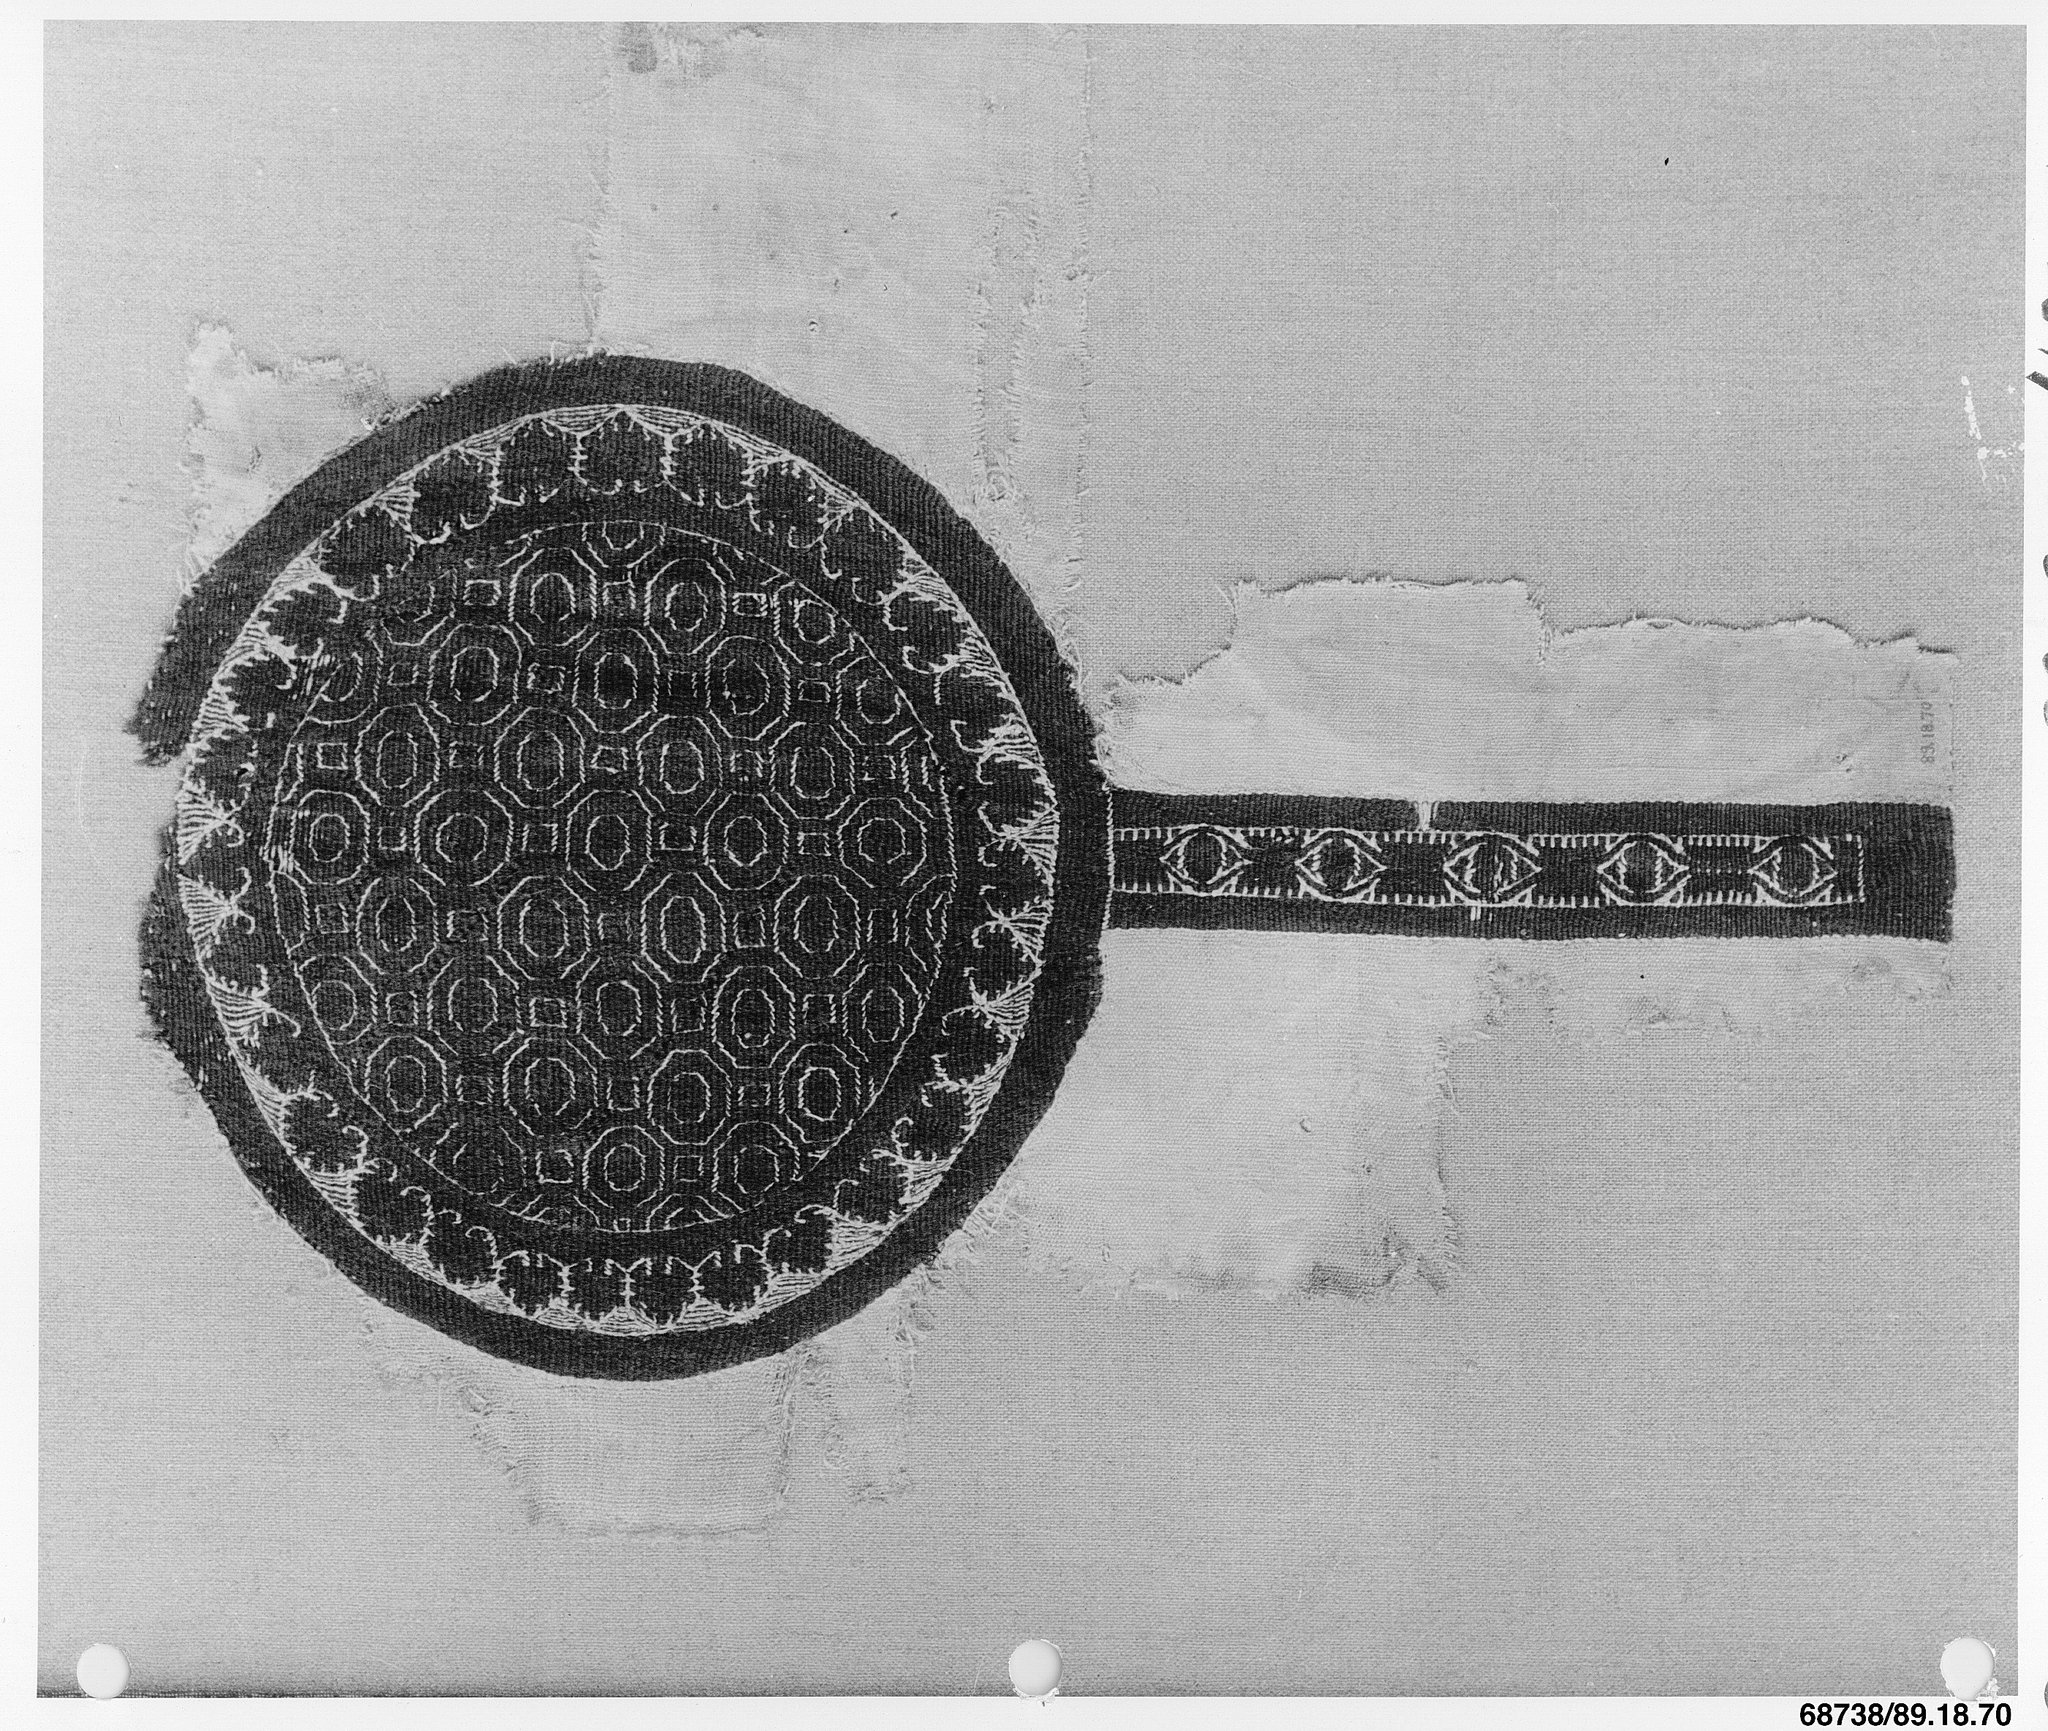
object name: textile fragment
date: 201-400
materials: linen, wool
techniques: weave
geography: egypt